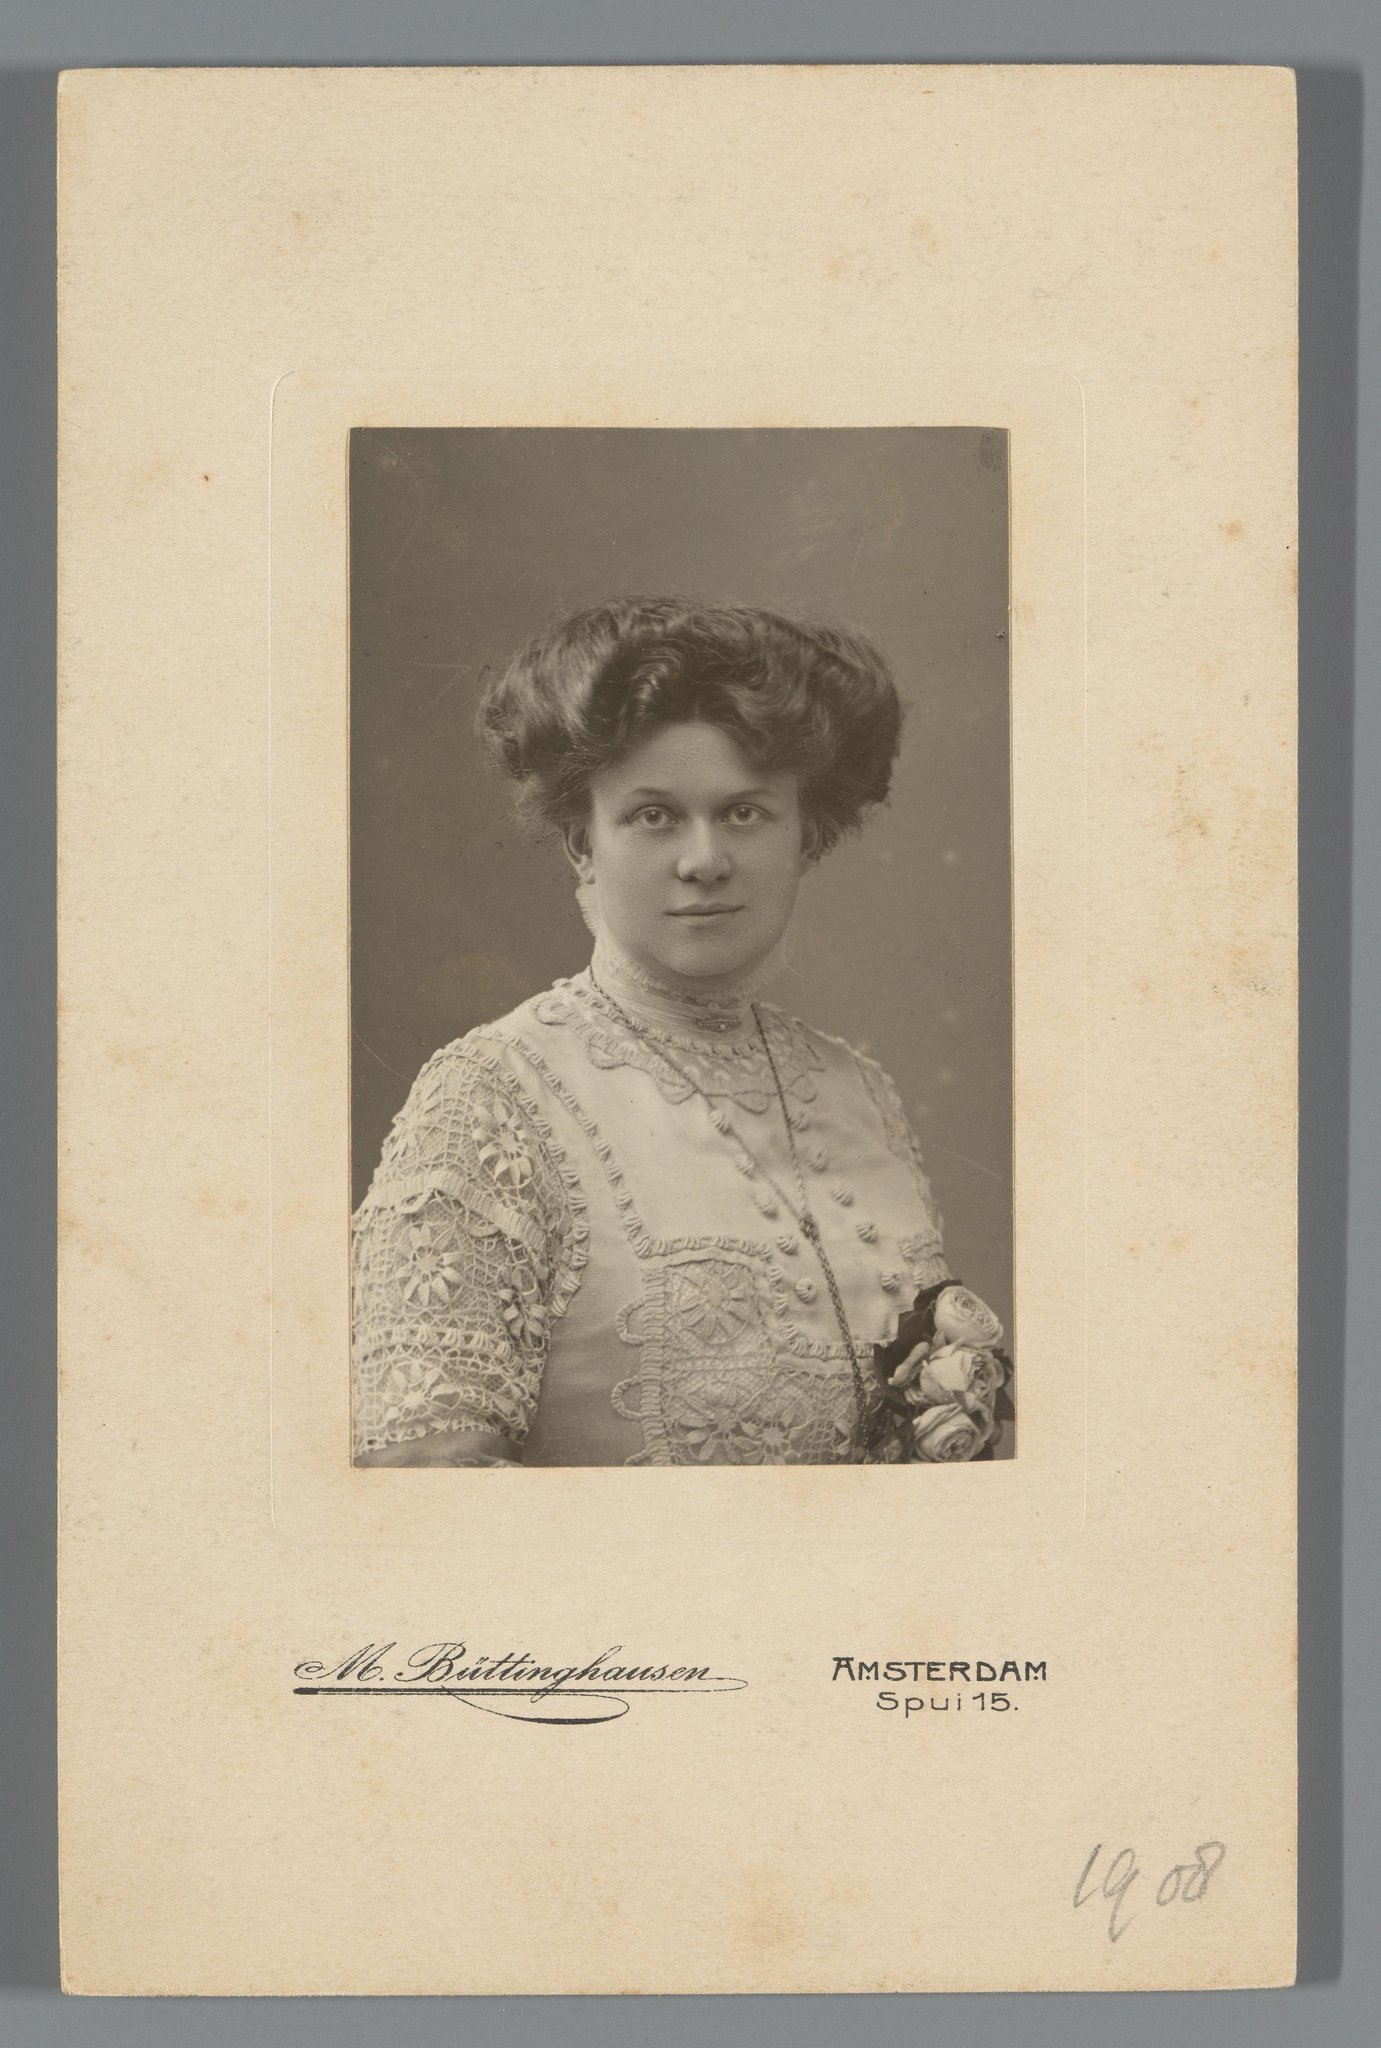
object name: cabinet photograph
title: Portret van Caroline L. van den Berg-Van den Berg (Line)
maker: max büttinghausen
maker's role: fotograaf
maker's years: 1847-1906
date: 1908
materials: cardboard, photographic support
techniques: albumen print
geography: spui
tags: the hague, caroline louise van den berg-van den berg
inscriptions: inscription: ‘Moeder 1908 ...’, date: ‘1908’, inscription: ‘M. Büttinghausen AMSTERDAM / Spui 15.’